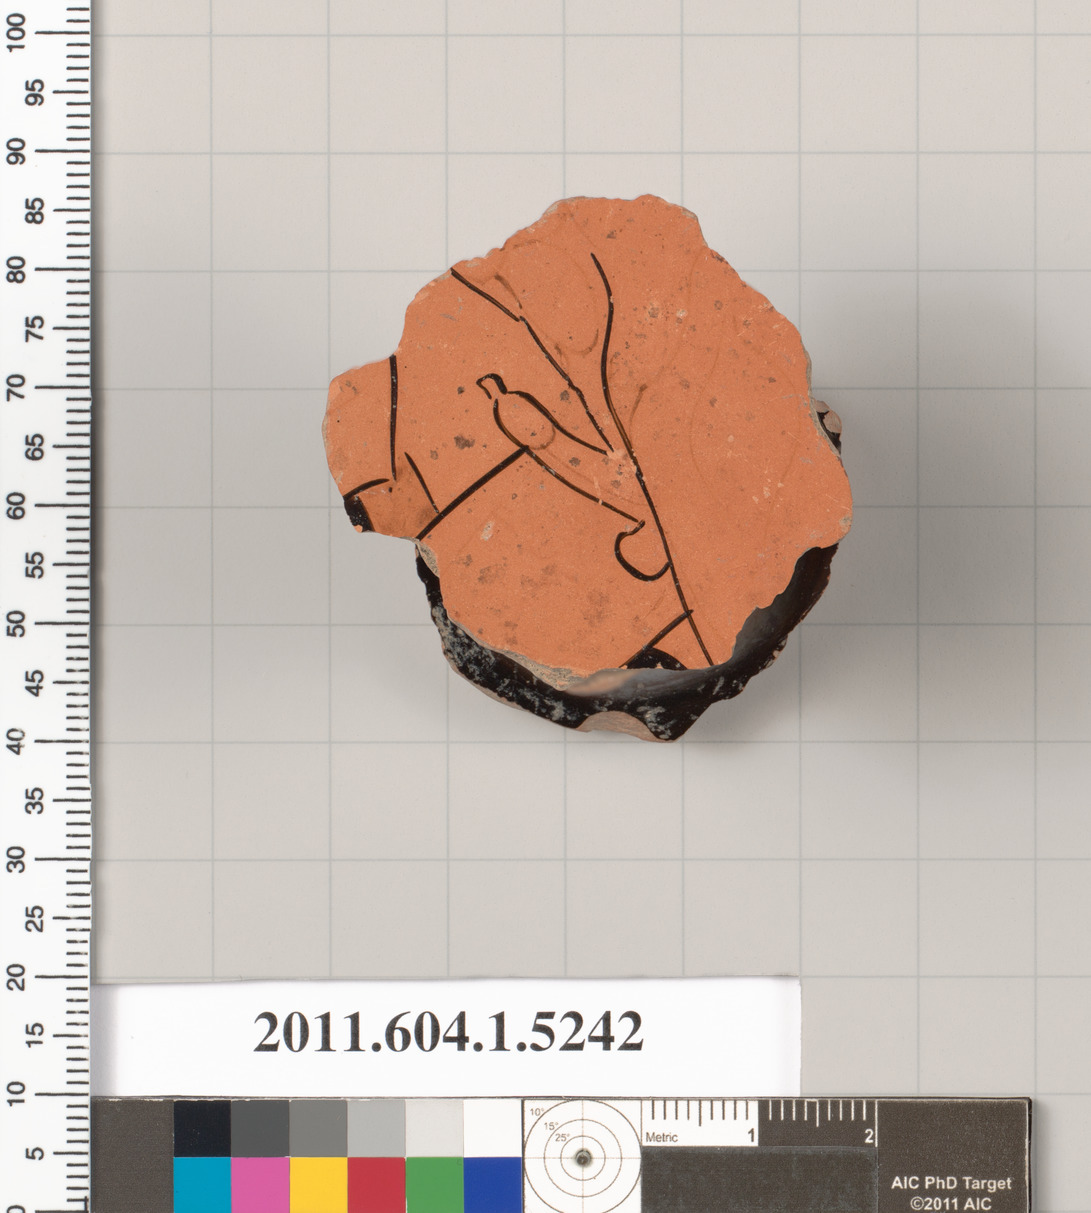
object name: kylix fragment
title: Terracotta fragment of a kylix (drinking cup)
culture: greek, attic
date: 520-500 BCE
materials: terracotta